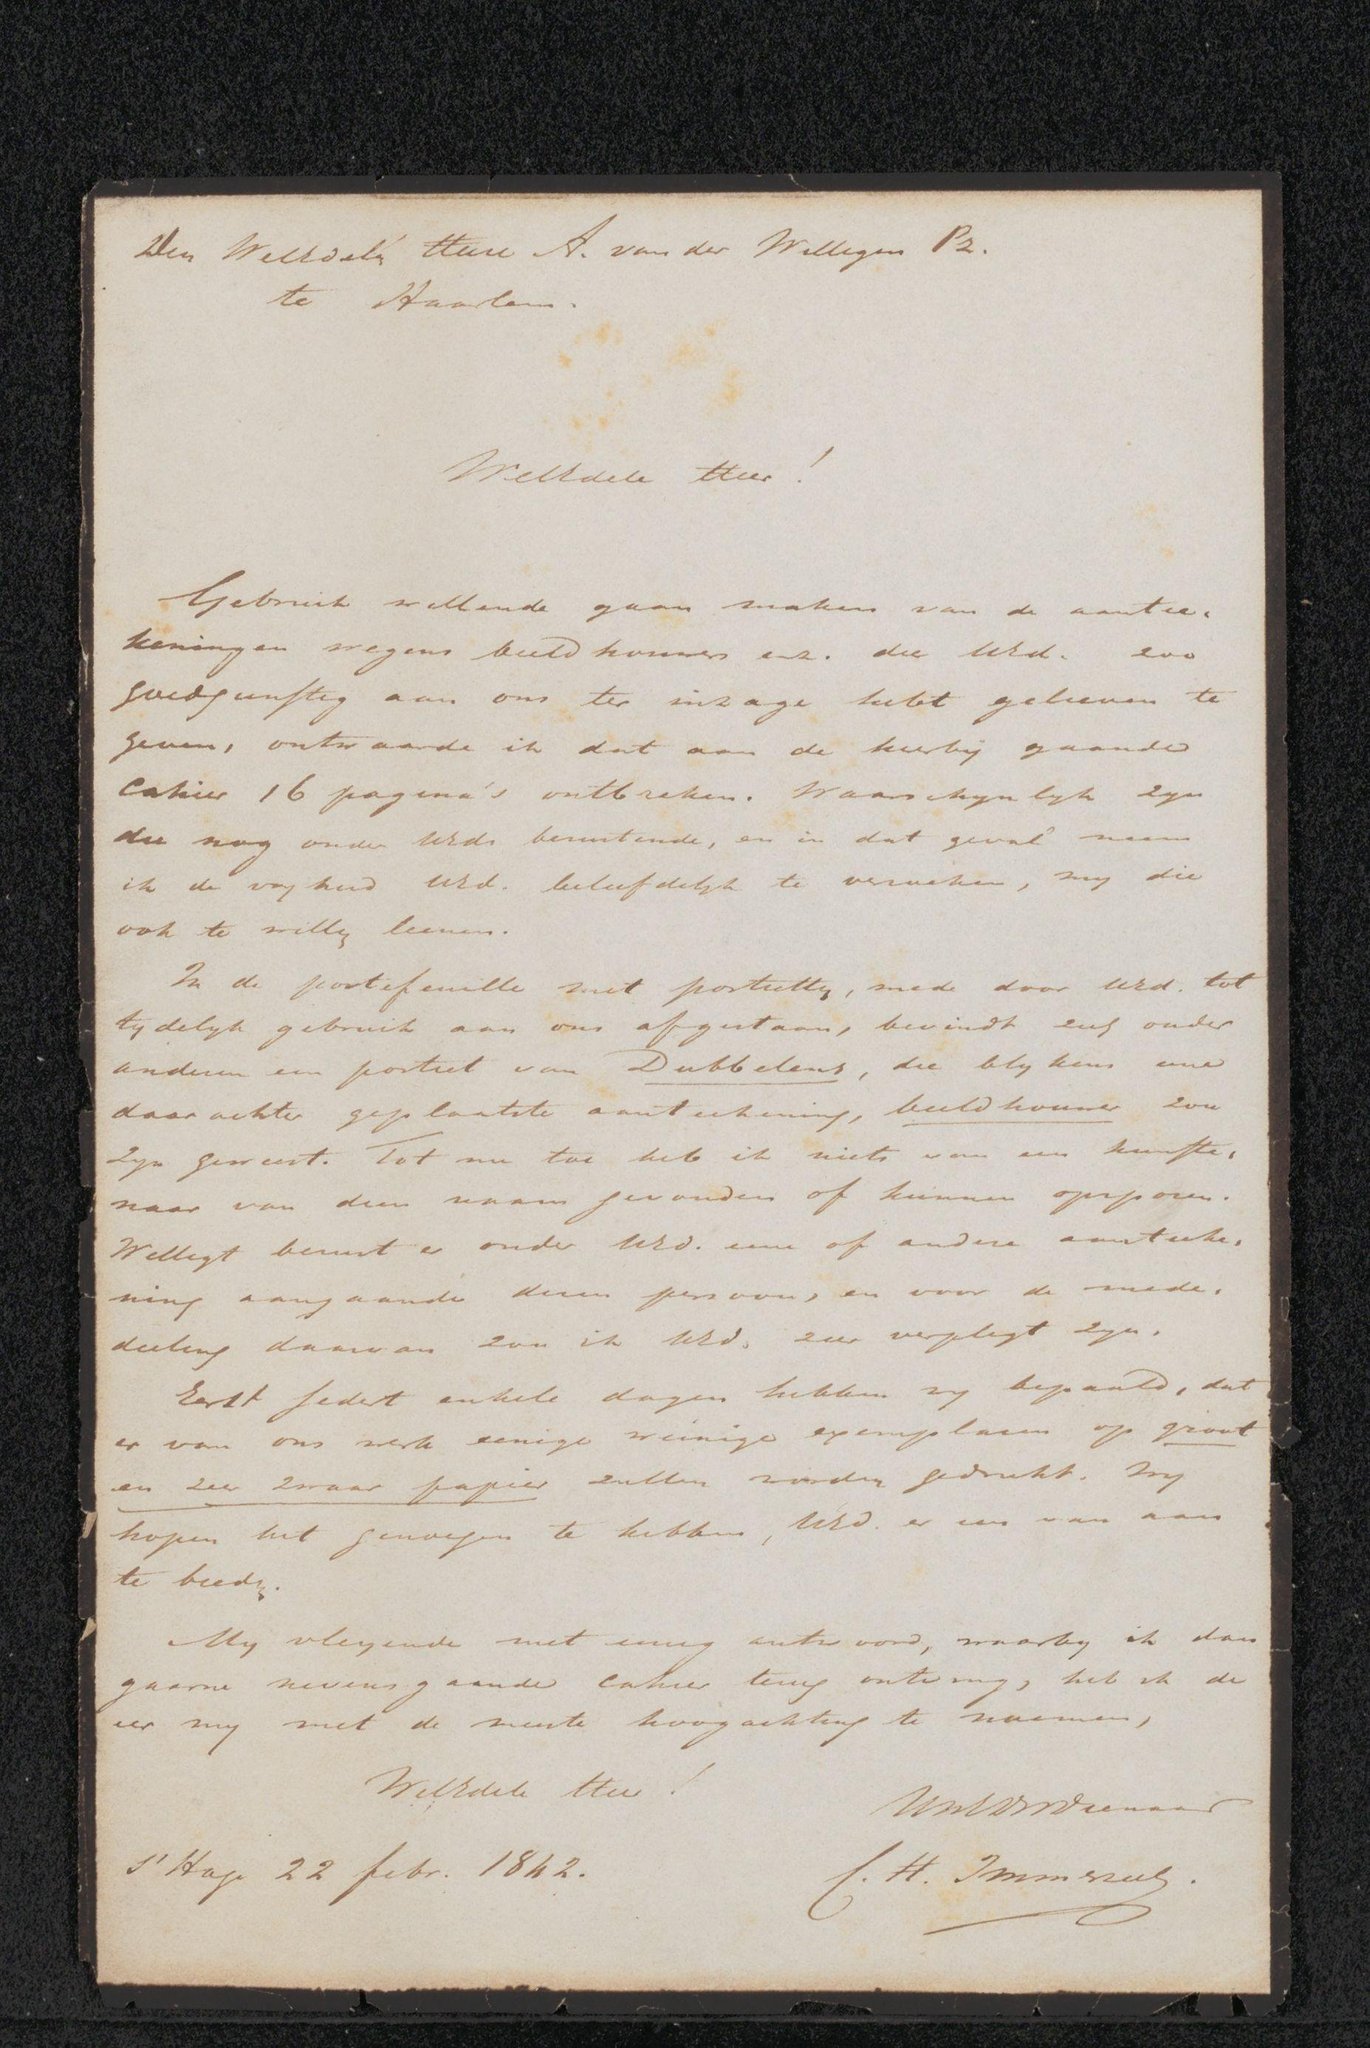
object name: letter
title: Brief aan Adriaan van der Willigen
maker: charles henri immerzeel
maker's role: jurist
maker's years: 1803-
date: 1842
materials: ink, paper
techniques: pen, writing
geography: the hague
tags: haarlem, adriaan van der willigen, sculpture, historical persons (portraits and scenes from the life), printed matter